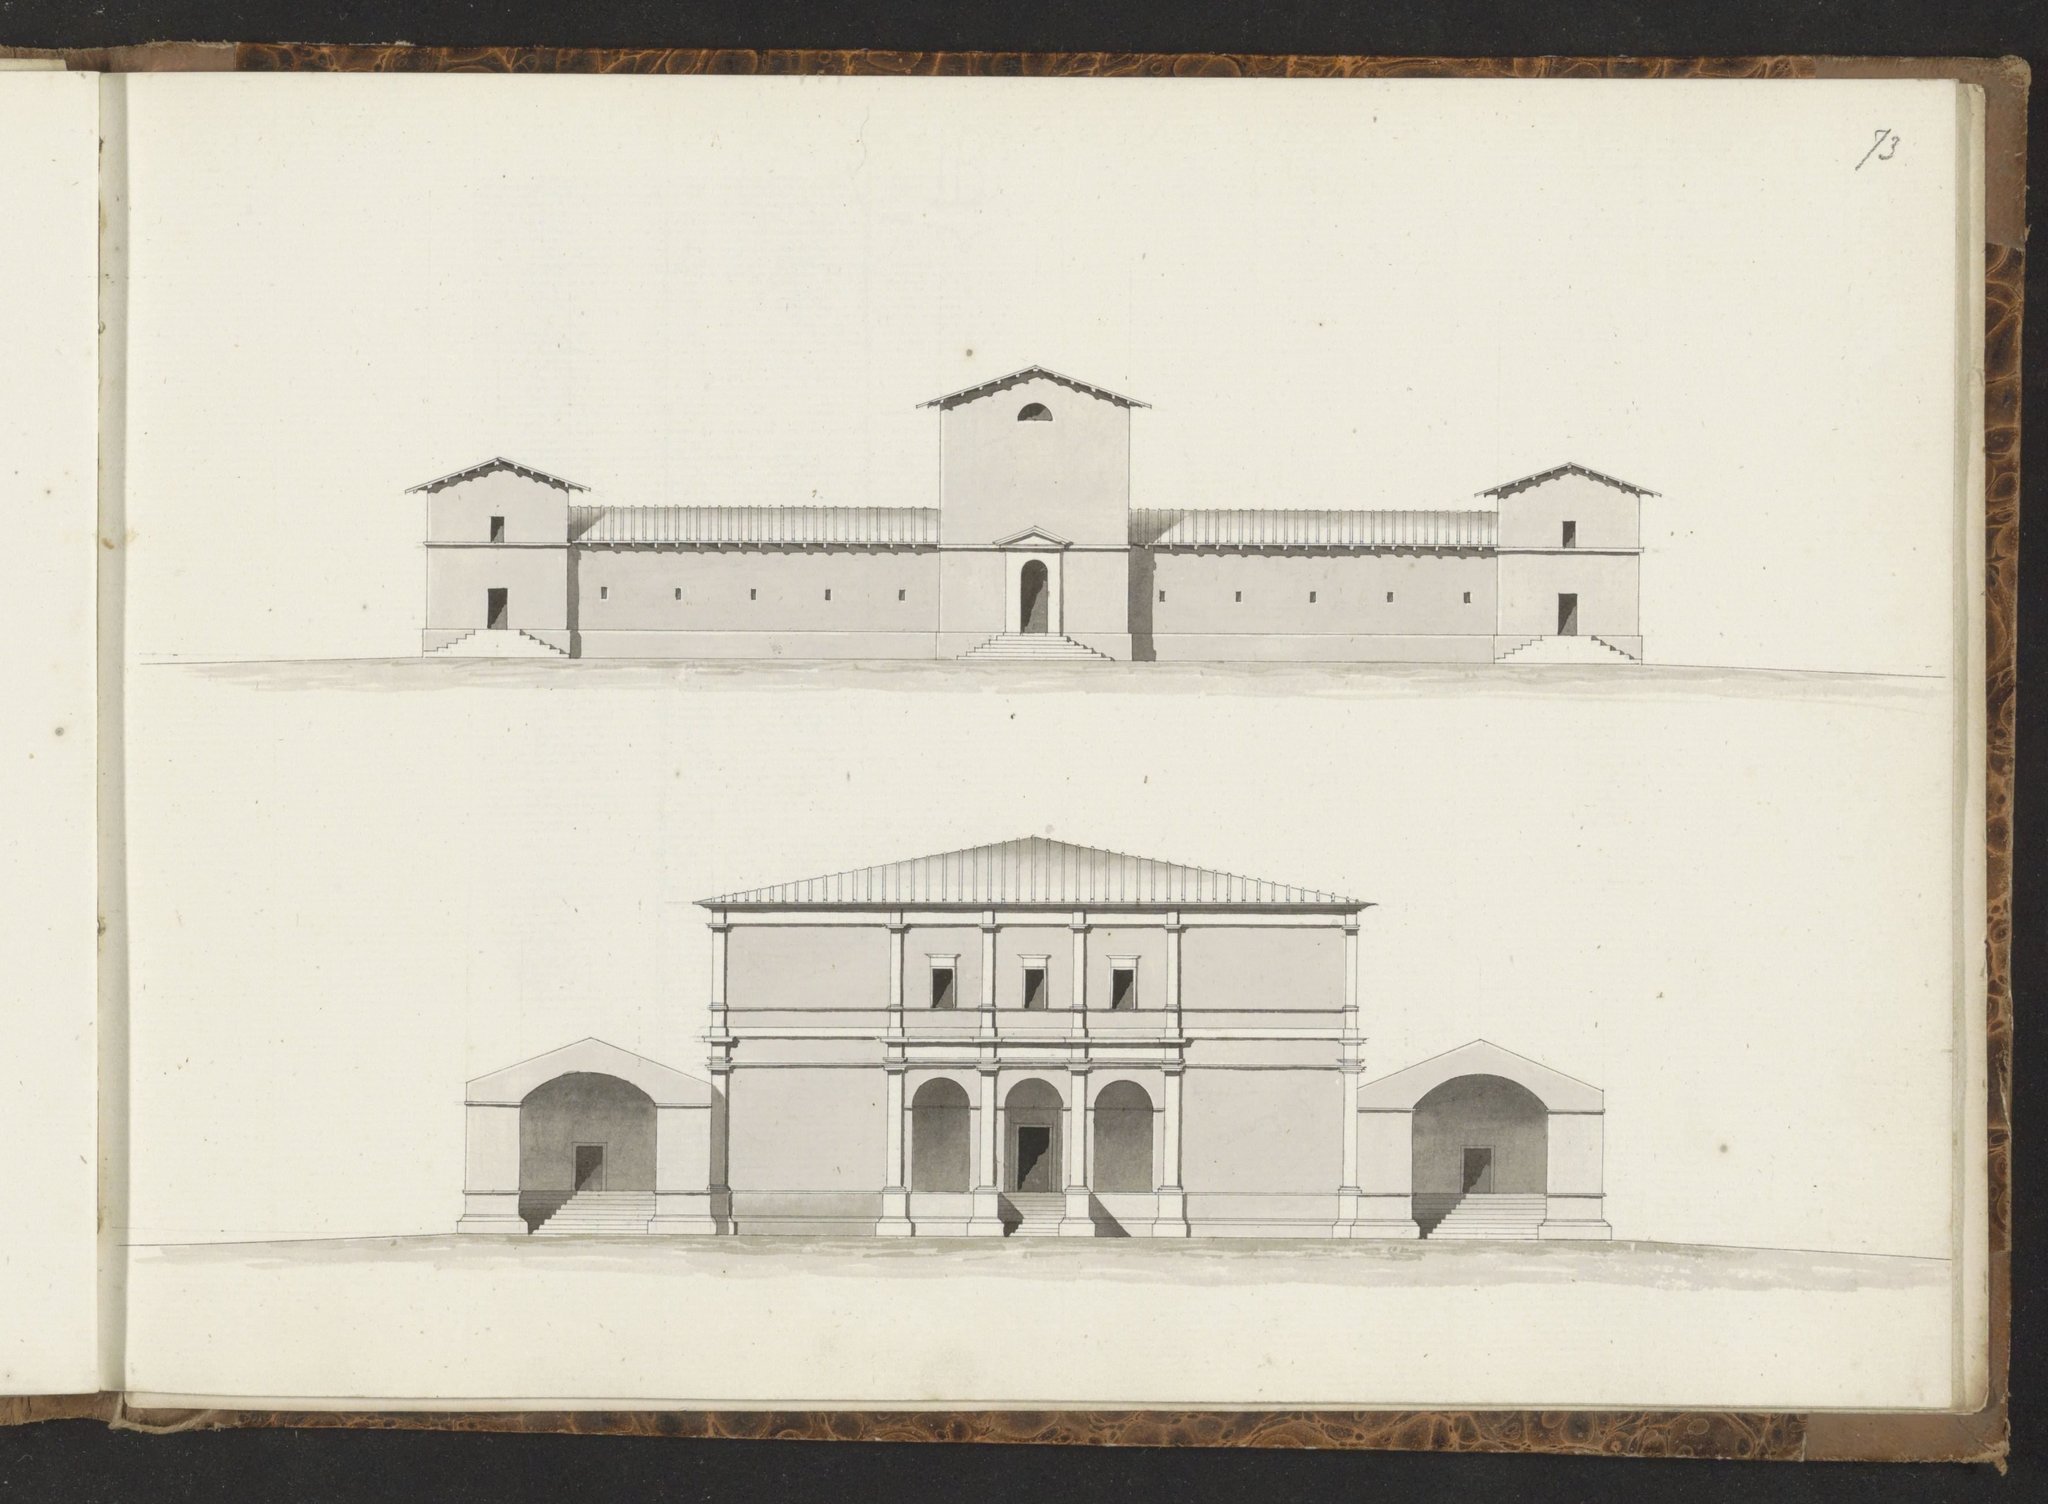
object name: sketchbook leaf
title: Voorgevels van twee villa's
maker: willem springer jr.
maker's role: draughtsman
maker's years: 1815-1907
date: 1825-1907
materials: ink, paper, pencil, watercolor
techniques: brush, pen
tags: villa, façade (of house or building)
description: Pagina 73 uit een schetsboek met 86 pagina's.